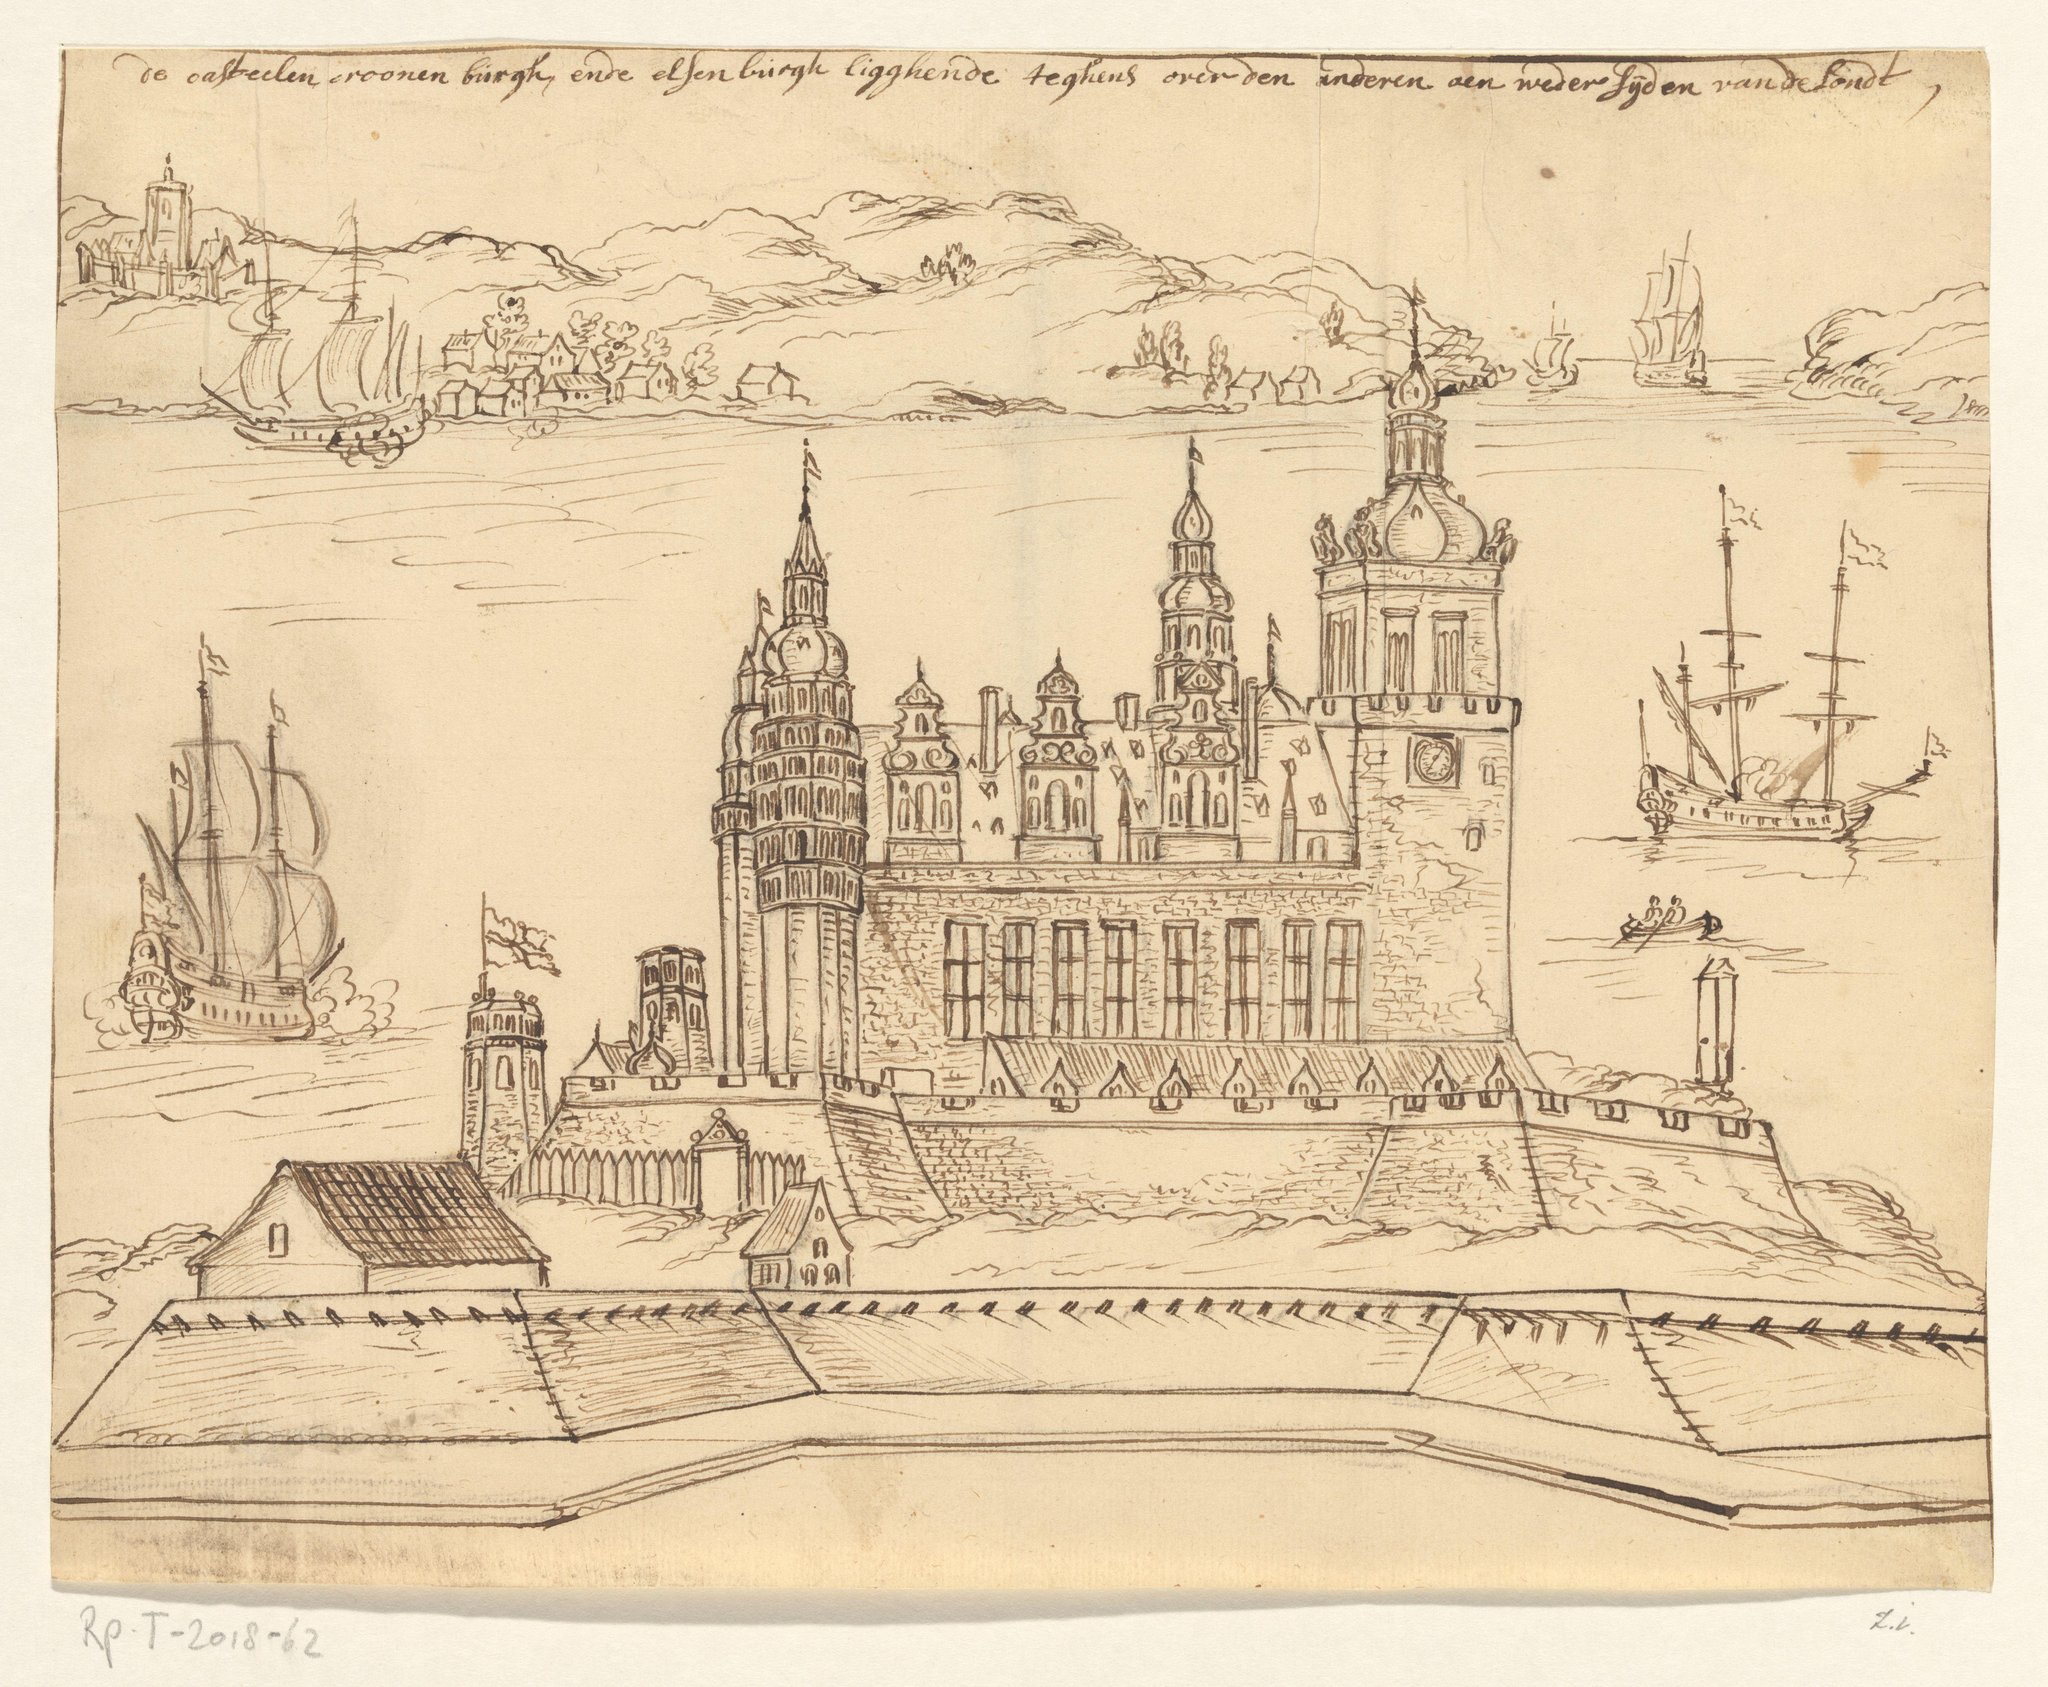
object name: drawing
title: Gezicht op Kronborg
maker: Anonymous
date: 1632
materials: ink, paper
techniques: pen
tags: castle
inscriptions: collector's mark: Lugt 2228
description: Tekening is een schets voor of gemaakt naar een prent ook gebruikt in: Iournael, vande legatie, gedaen inde Iaren 1627 en 1628 (...). Amsterdam: Michiel Colijn, 1632.